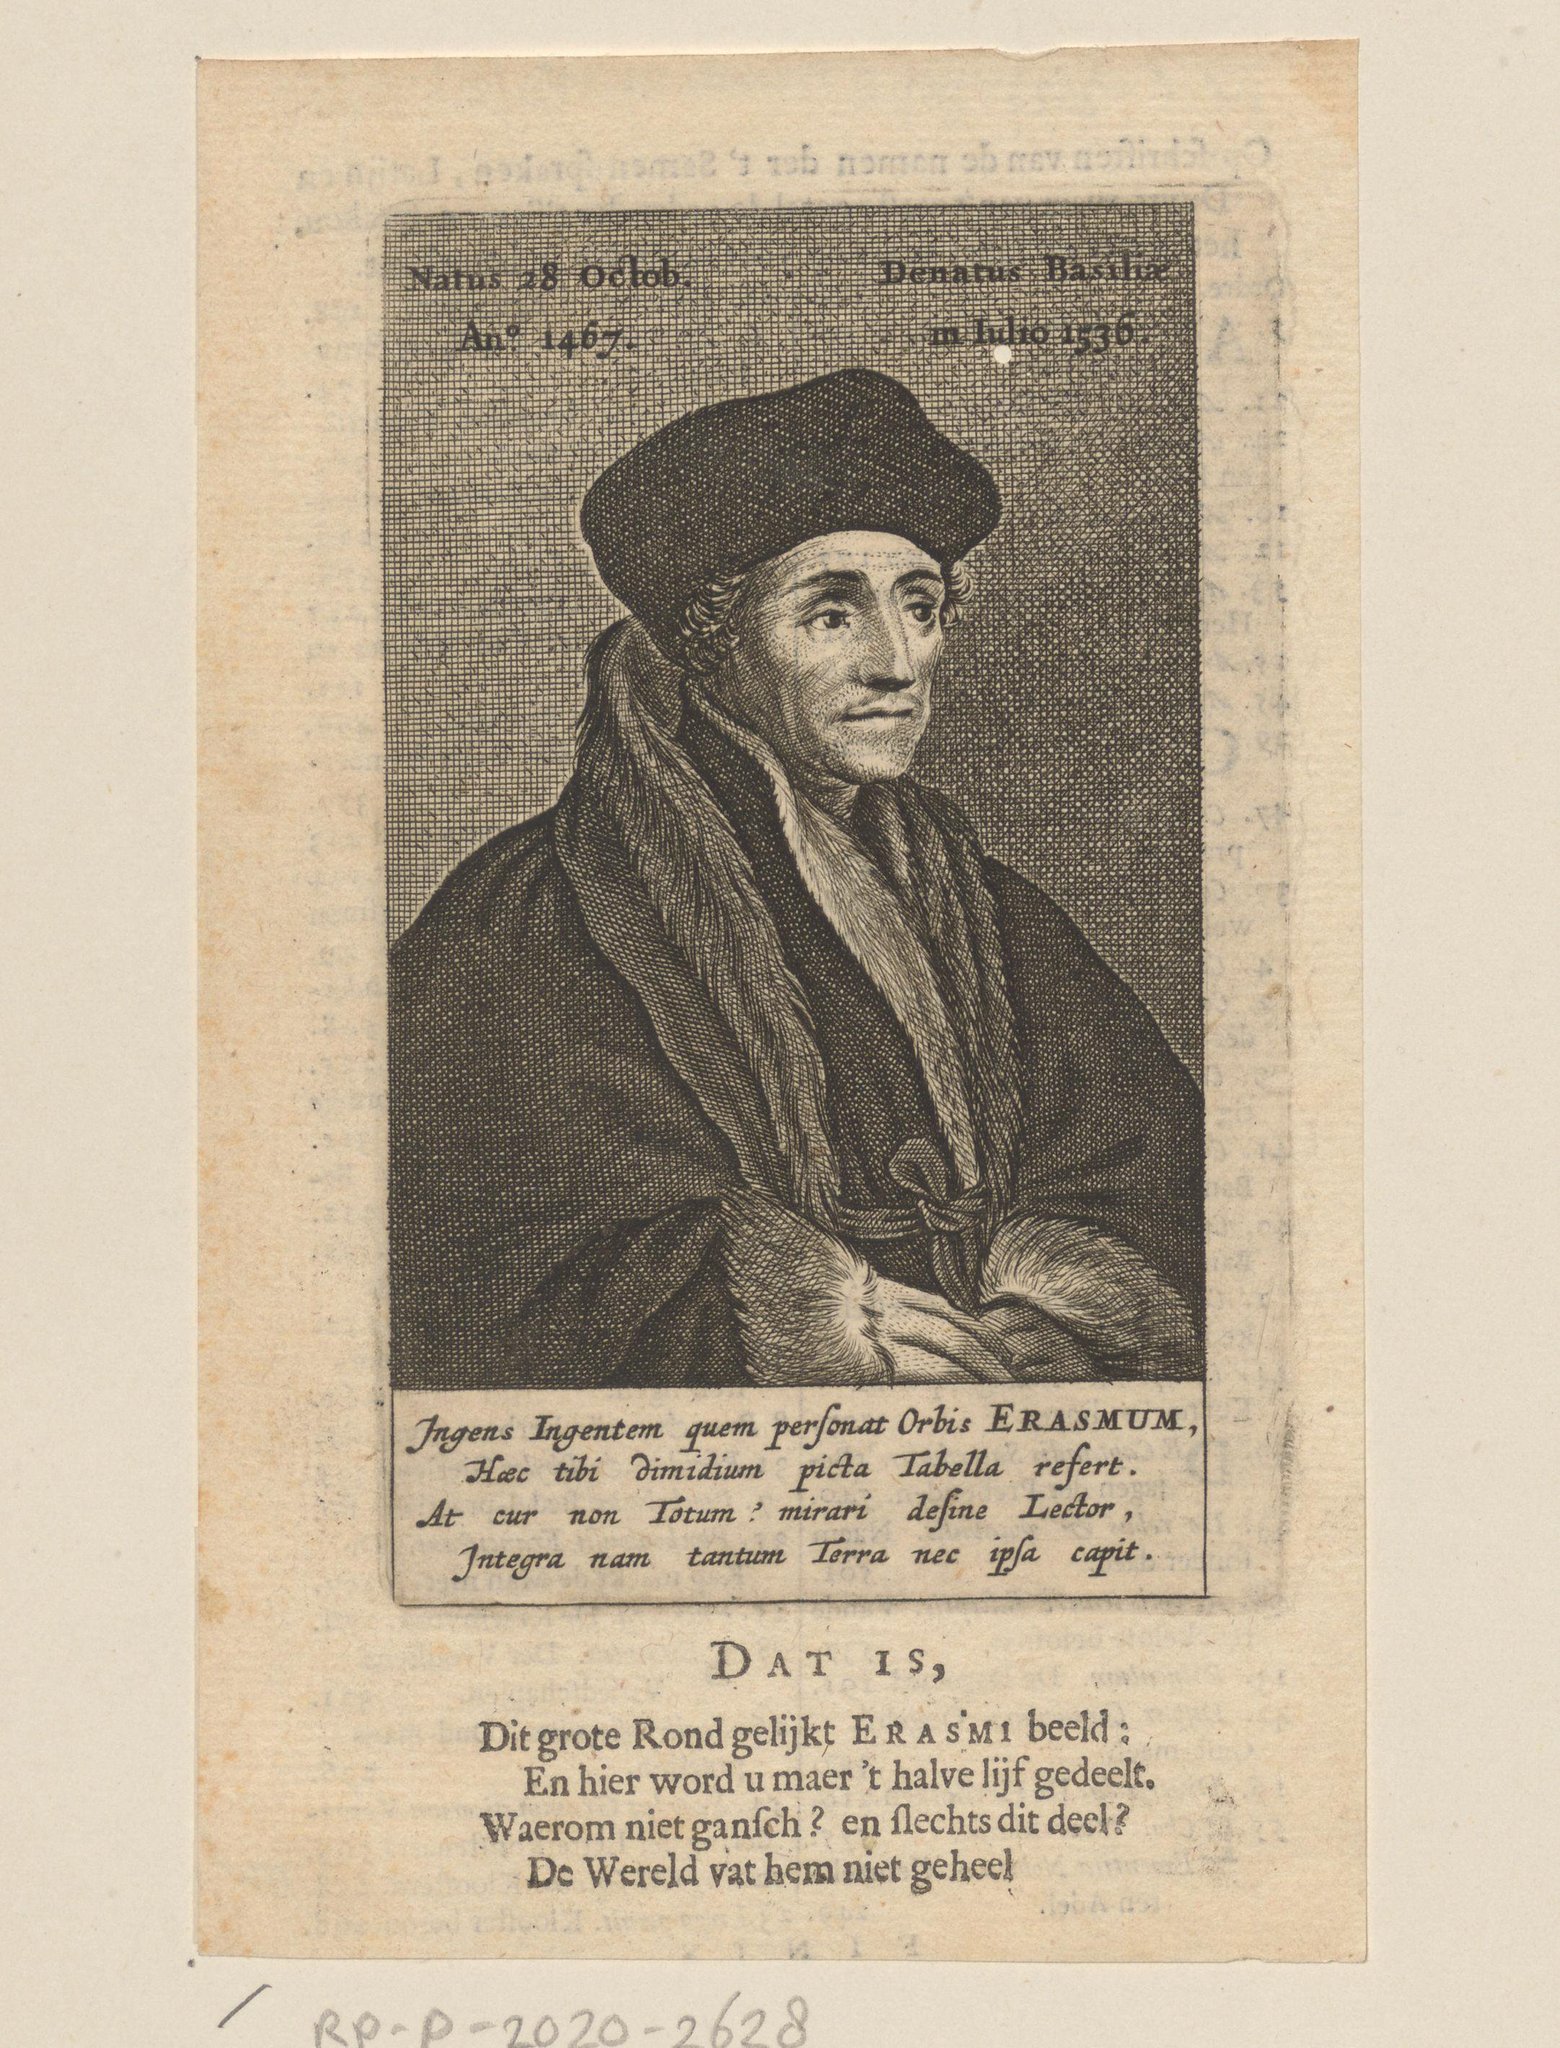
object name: book illustration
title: Portret van Desiderius Erasmus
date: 1664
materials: paper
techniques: engraving, letterpress printing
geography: northern netherlands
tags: rotterdam, desiderius erasmus, historical persons, scholar, philosopher (+ portrait of scholar, scientist)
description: Prent uit: Erasmus, Desiderius. Colloquia Familiara, dat is Gemeensame t'Samenspraken (...). Utrecht: Gijsbert van Zijll, 1664.